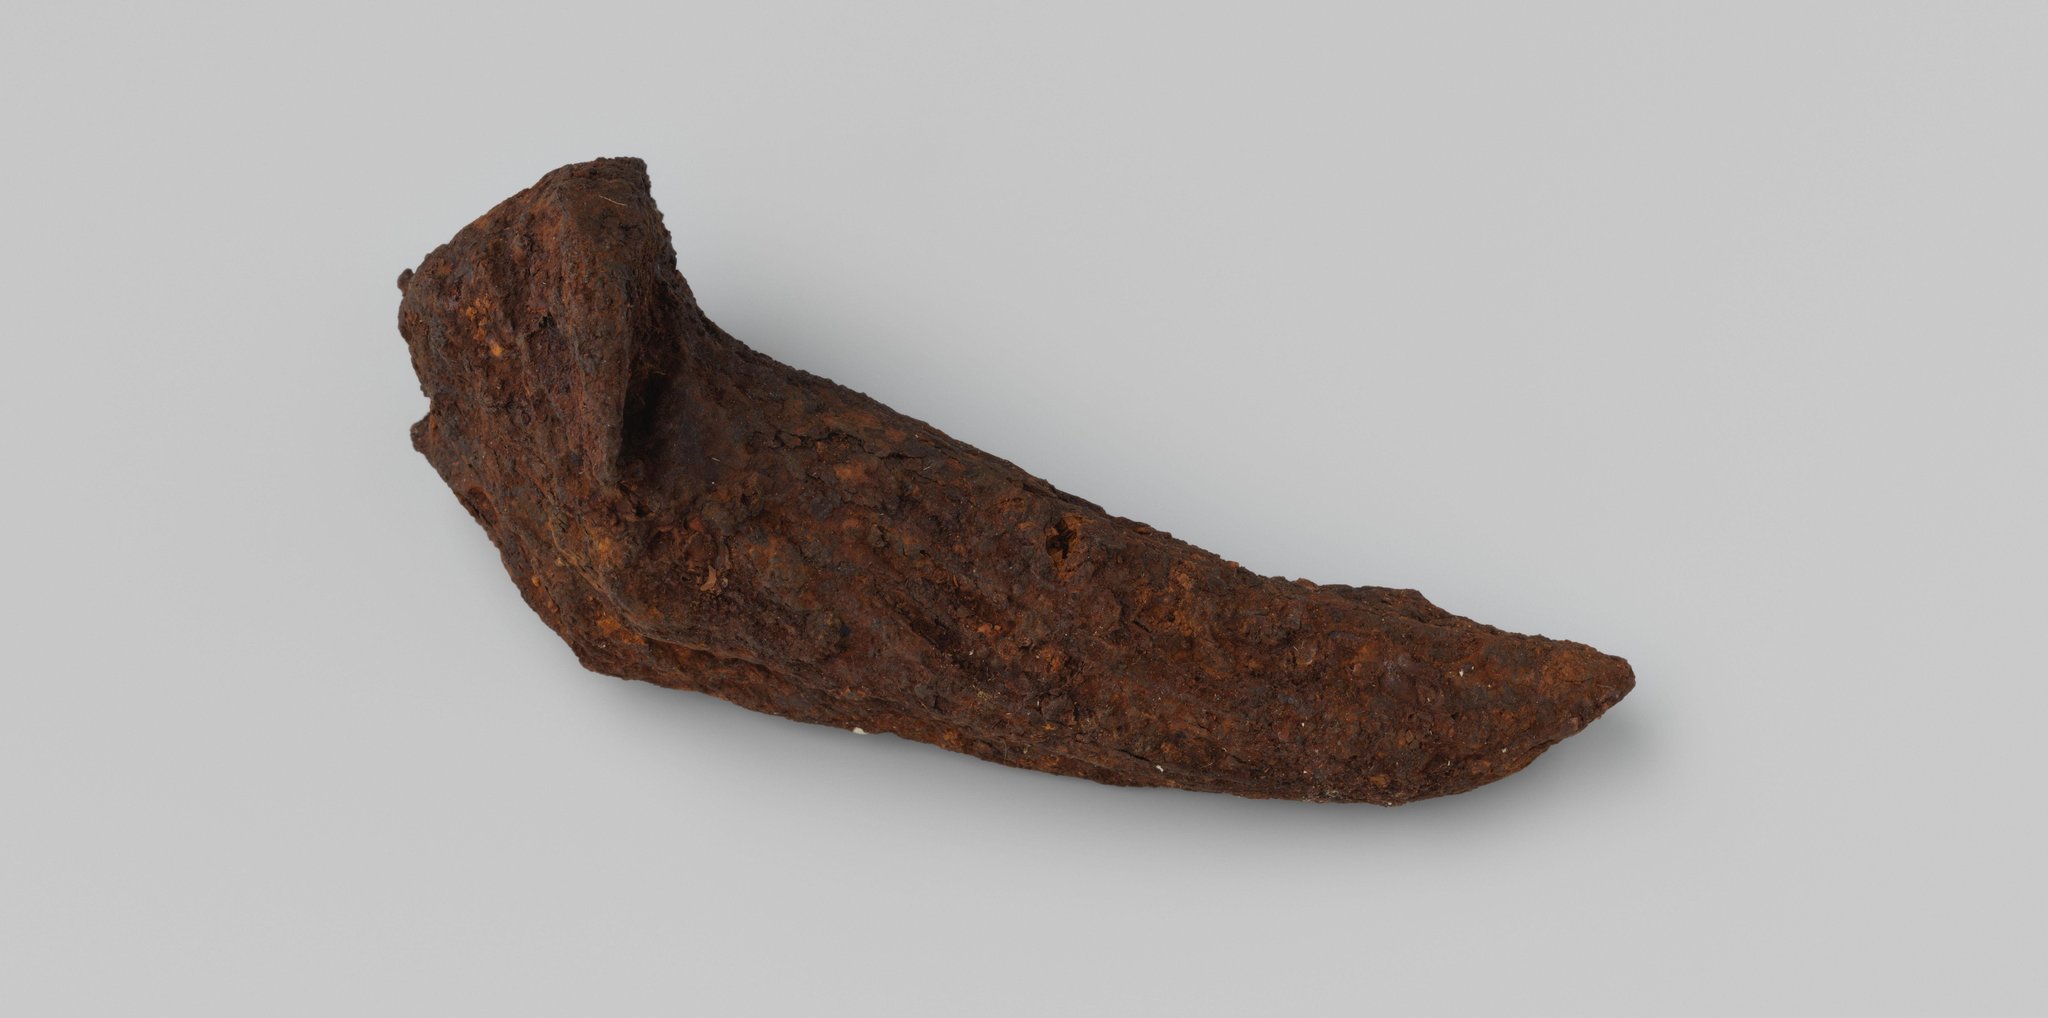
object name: nagel, spijker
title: Spijker afkomstig uit het wrak van de Oost-Indiëvaarder Hollandia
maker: Anonymous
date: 1700-1743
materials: iron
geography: netherlands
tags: verenigde oostindische compagnie, hollandia (schip)